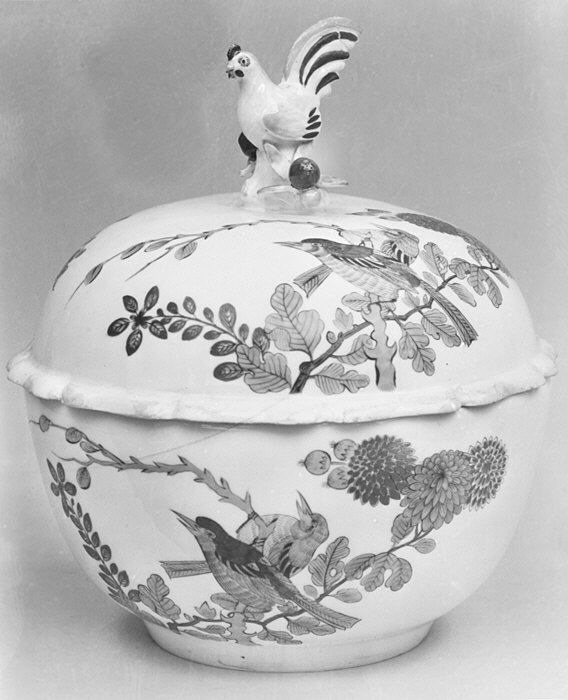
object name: bowl with cover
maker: meissen manufactory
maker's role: manufactory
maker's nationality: german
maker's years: 1710-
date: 1735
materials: hard paste porcelain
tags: birds,flowers